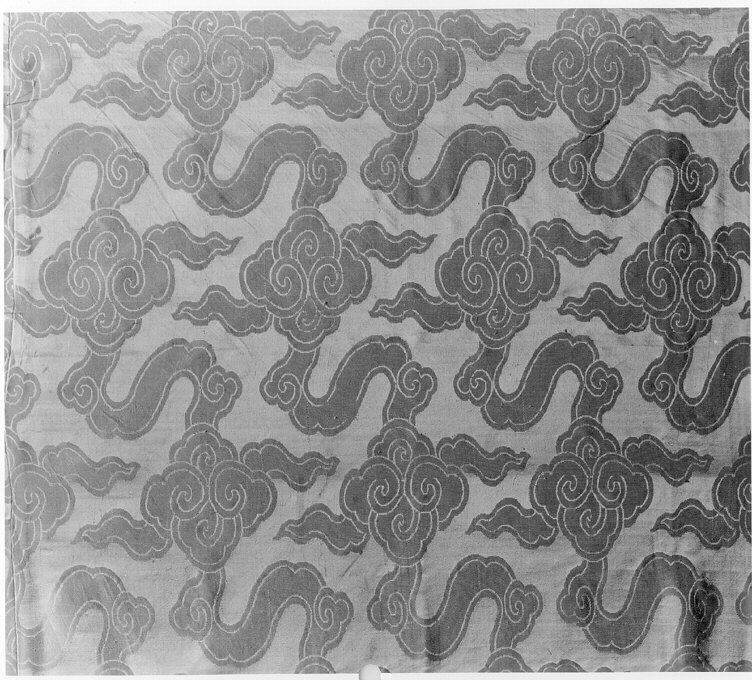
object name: piece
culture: chinese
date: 1801-1833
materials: silk